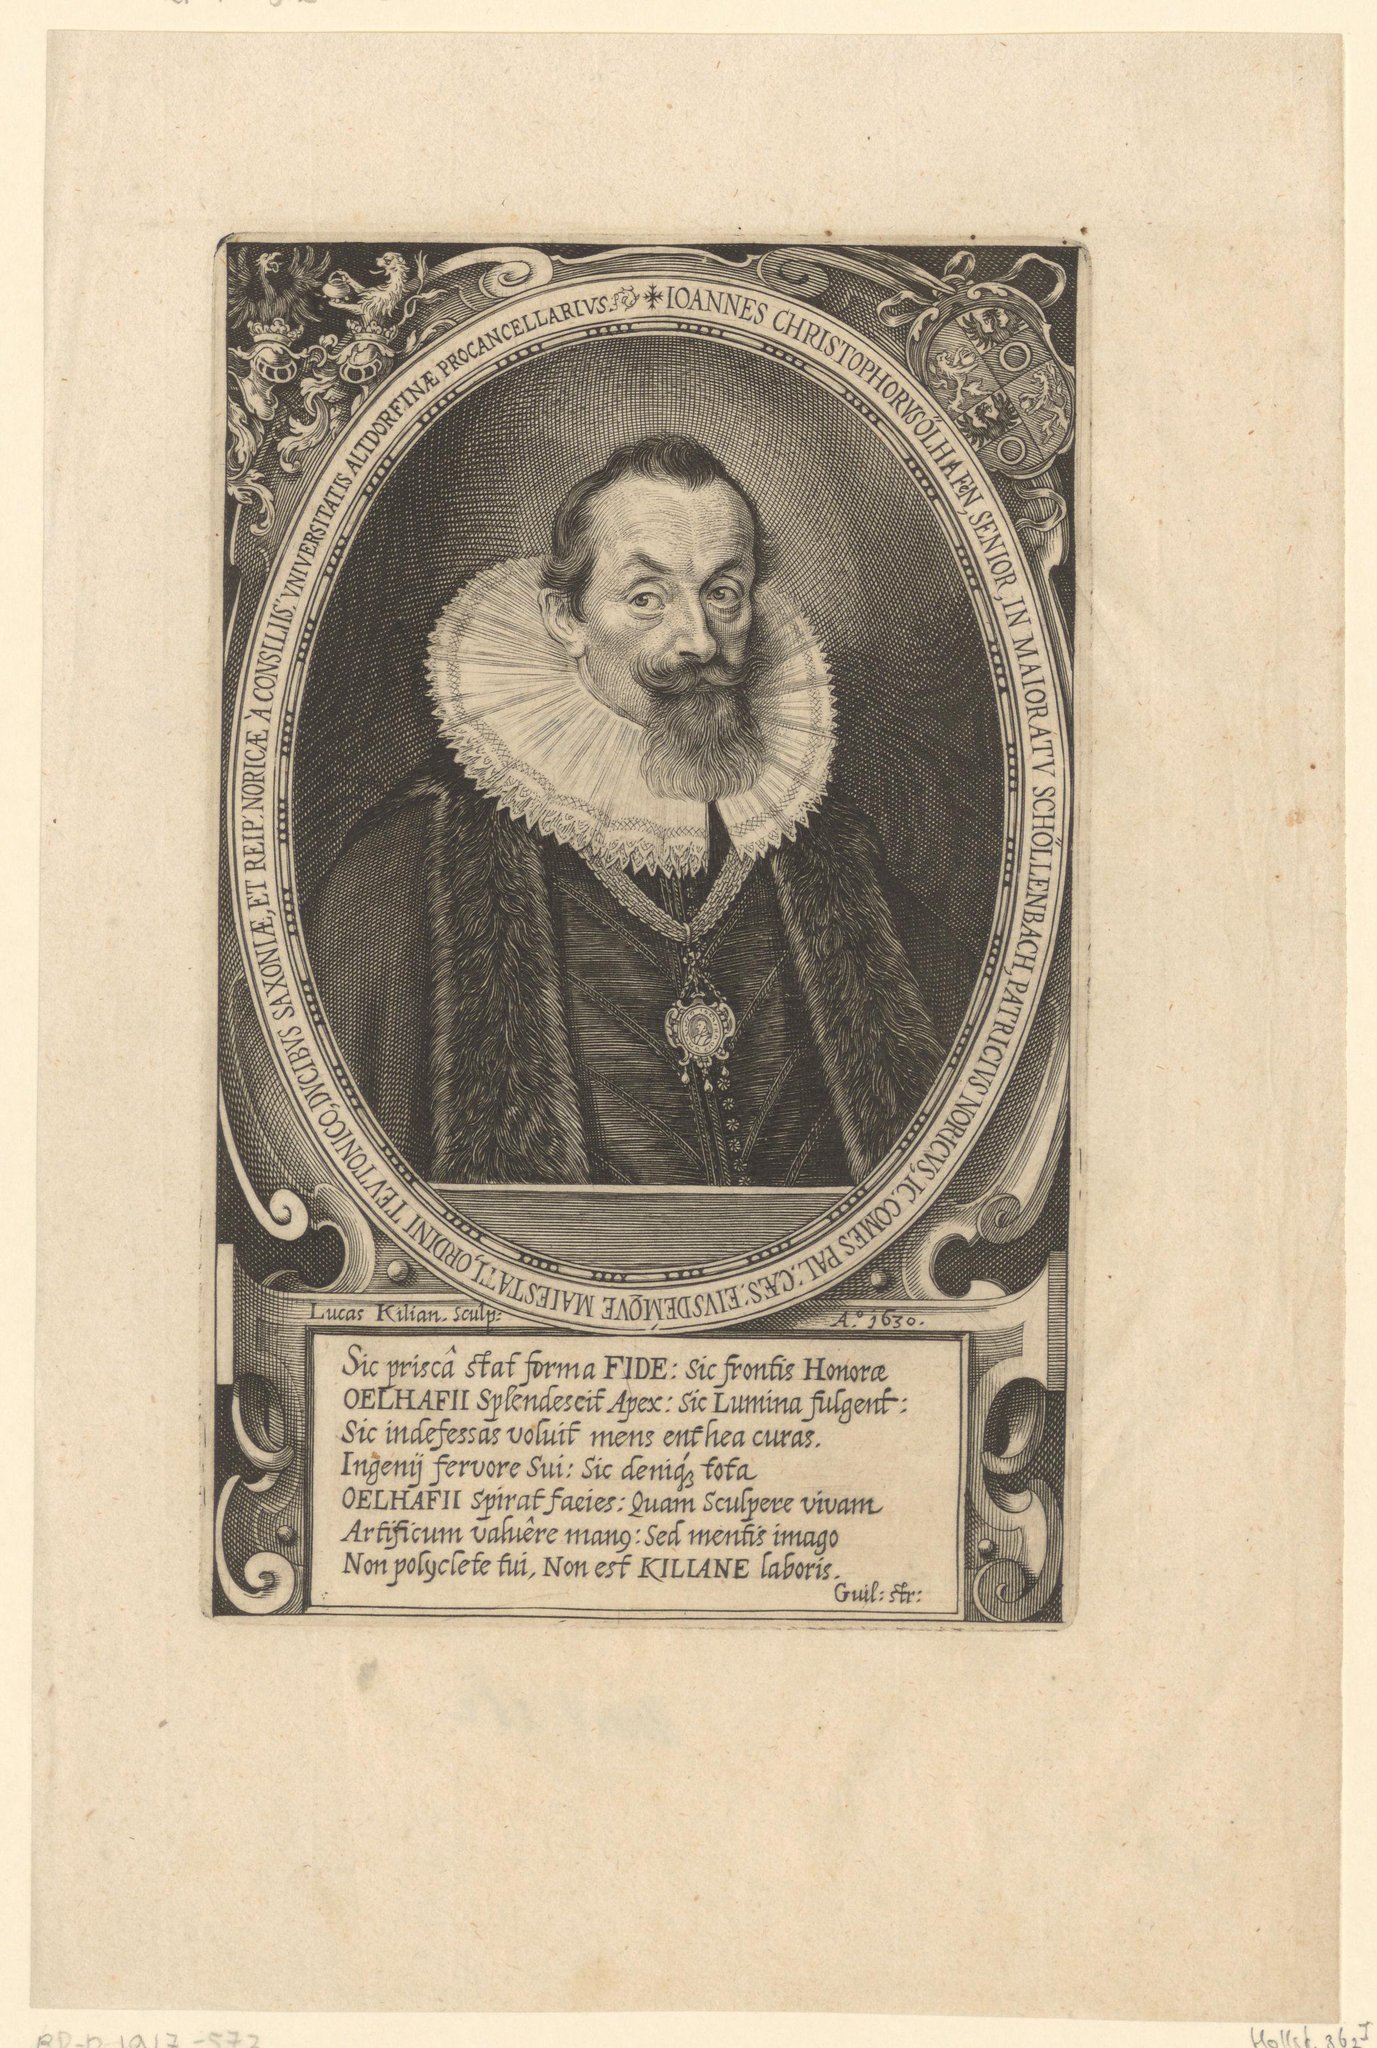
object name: print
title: Portret van Johann Christoph Oelhafen van Schöllenbach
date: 1630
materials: paper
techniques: engraving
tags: historical persons, lawyer, attorney at law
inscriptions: collector's mark: Lugt 2228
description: Tekst in het Latijn in de omlijsting en in de ondermarge.